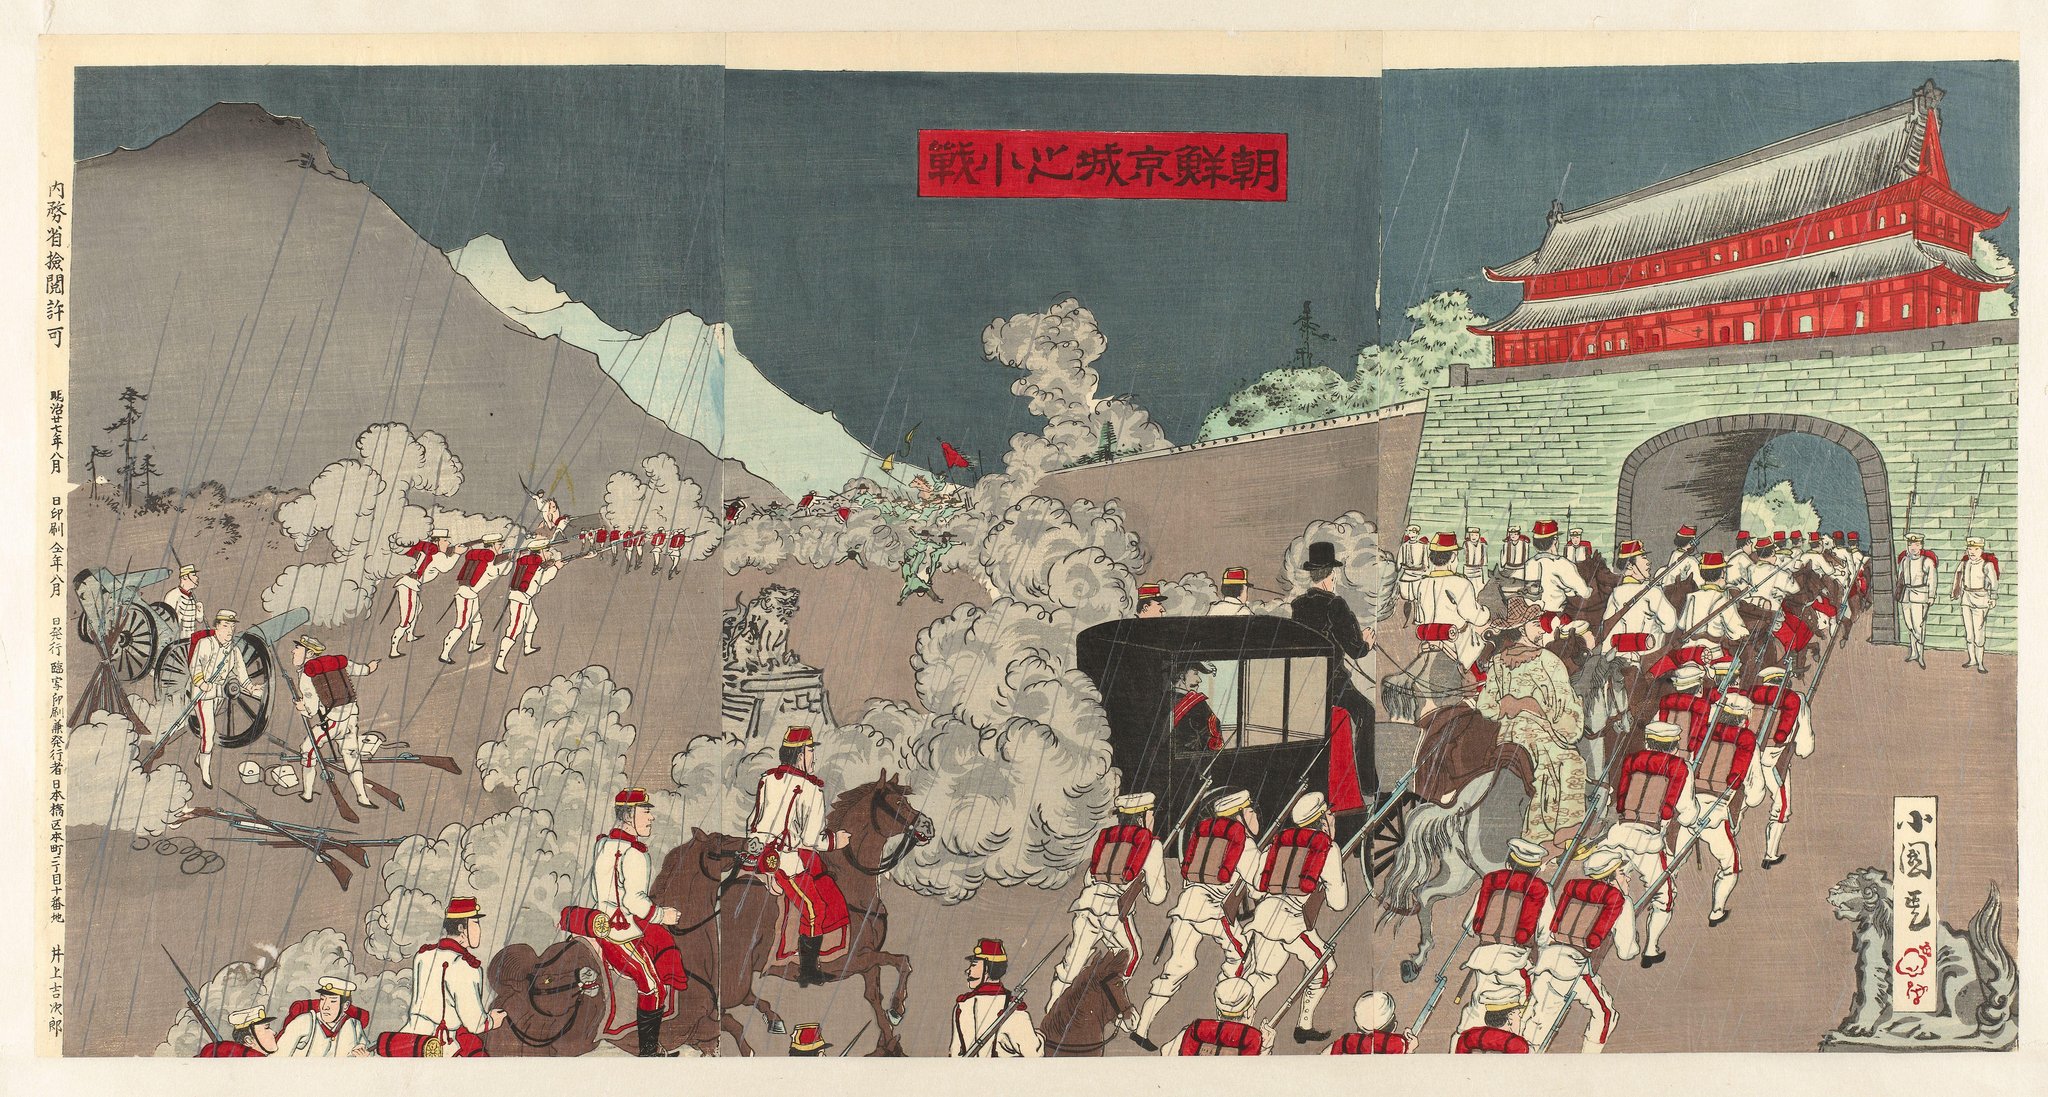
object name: triptych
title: Ôshima shôsa Seikan o yaburu no zu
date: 1894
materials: paper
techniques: woodcut, polish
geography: japan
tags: battle, firearms: cannon, firearms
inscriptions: label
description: Japanse troepen gekleed in een zomer uniform openen het vuur op het Chinese leger in Songhwan. Dit incident vond plaats op 28 juli 1894, tijdens de Eerste Chinees-Japanse Oorlog (1894-1895).